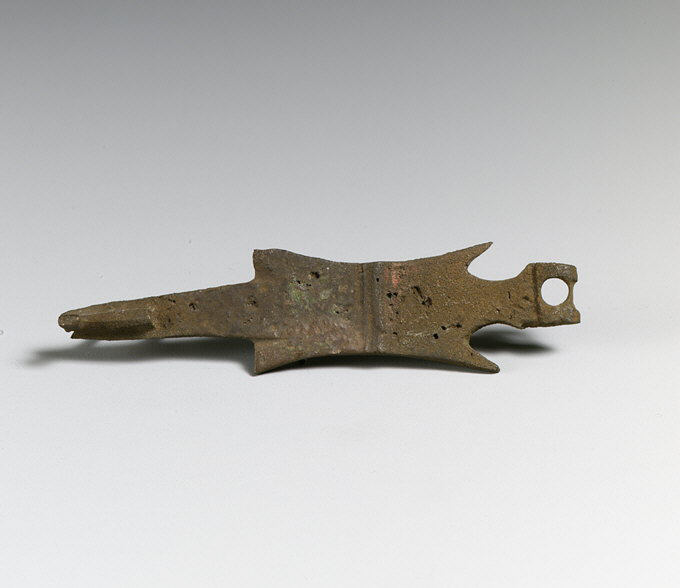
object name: hasp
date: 7000 BCE-330 CE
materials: bronze